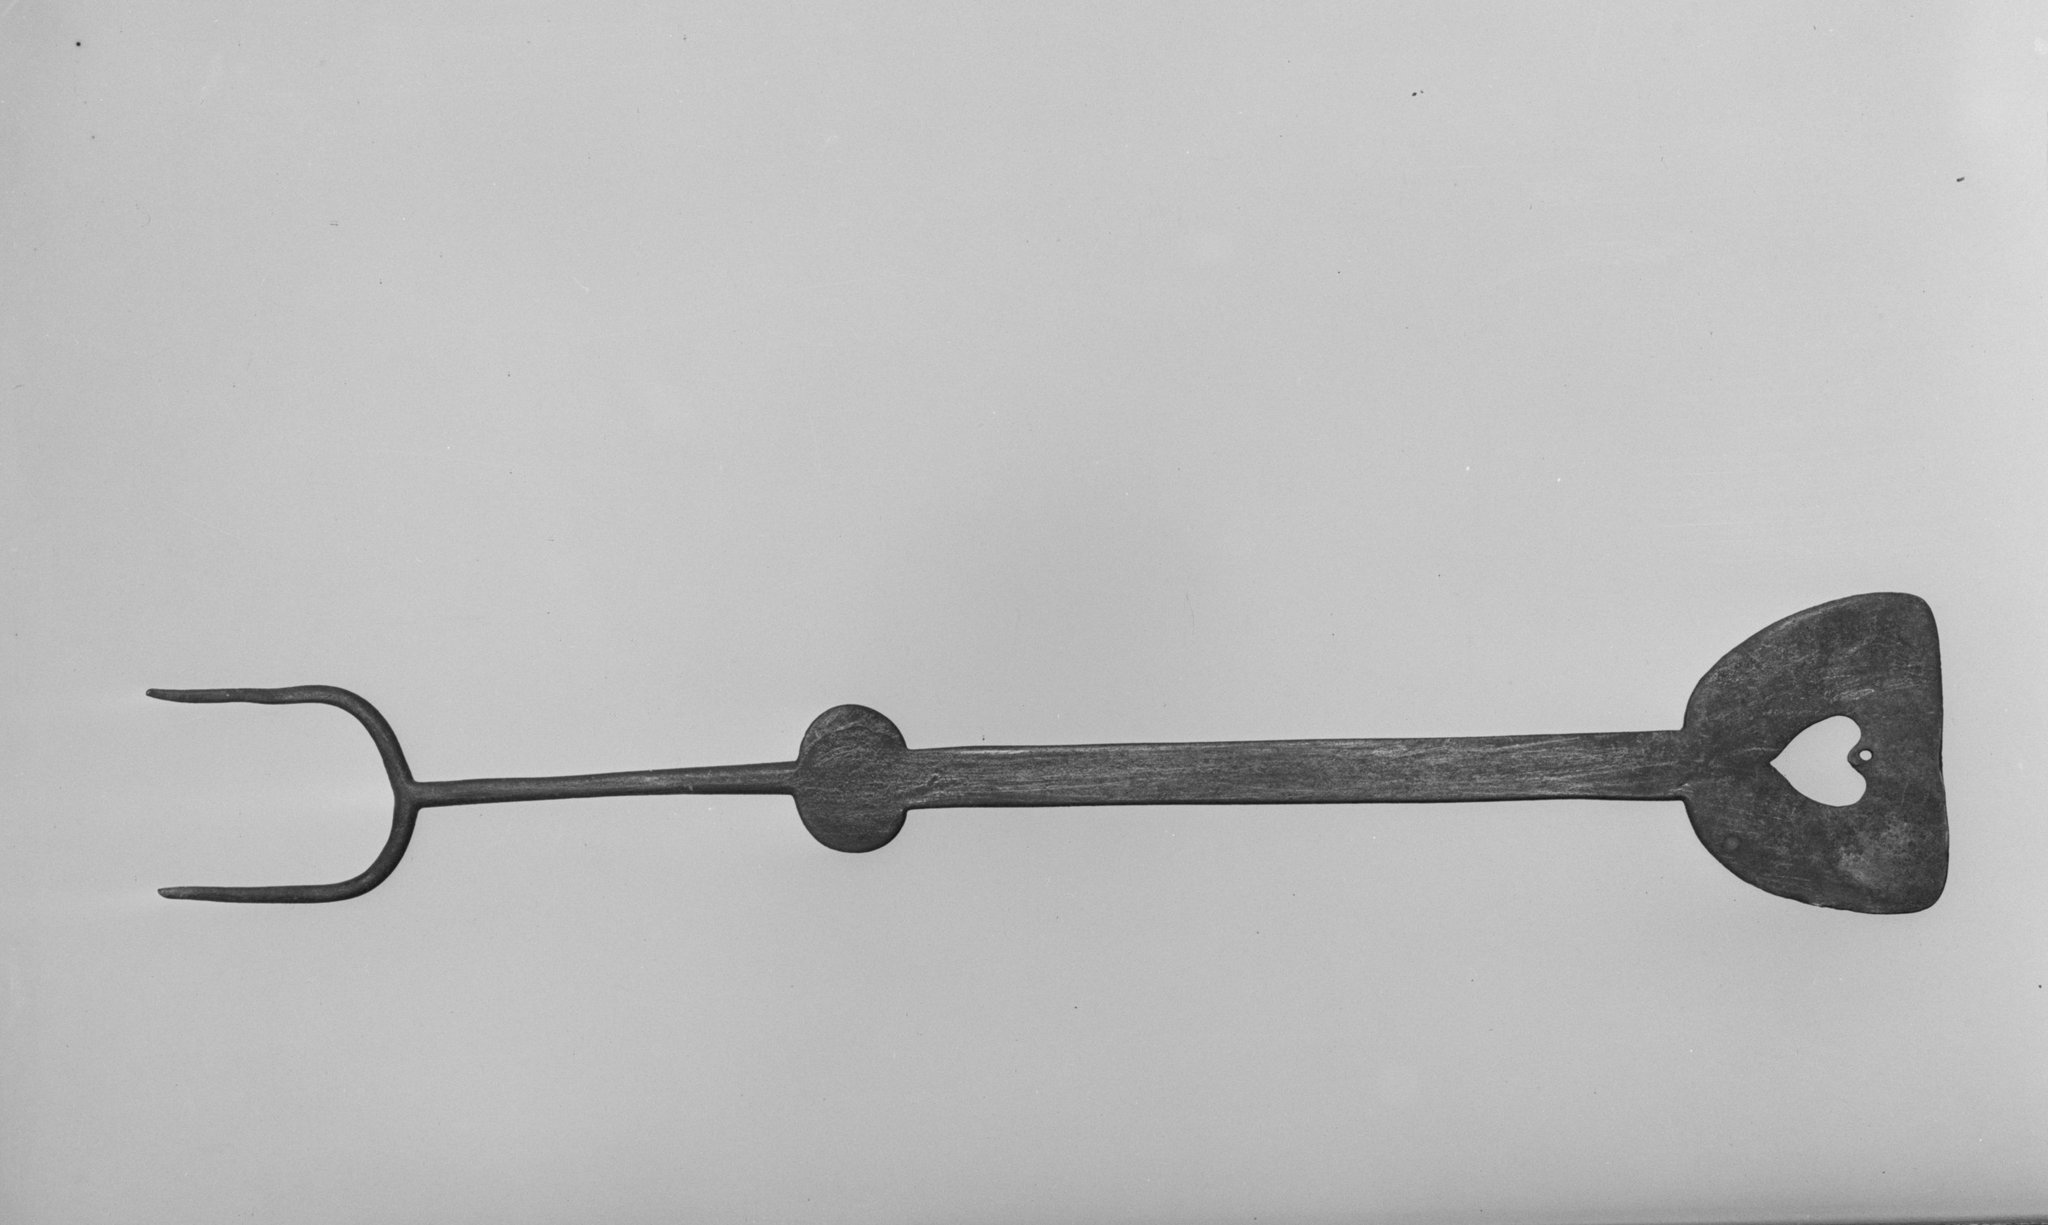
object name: fork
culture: american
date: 1700-1800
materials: iron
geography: united states